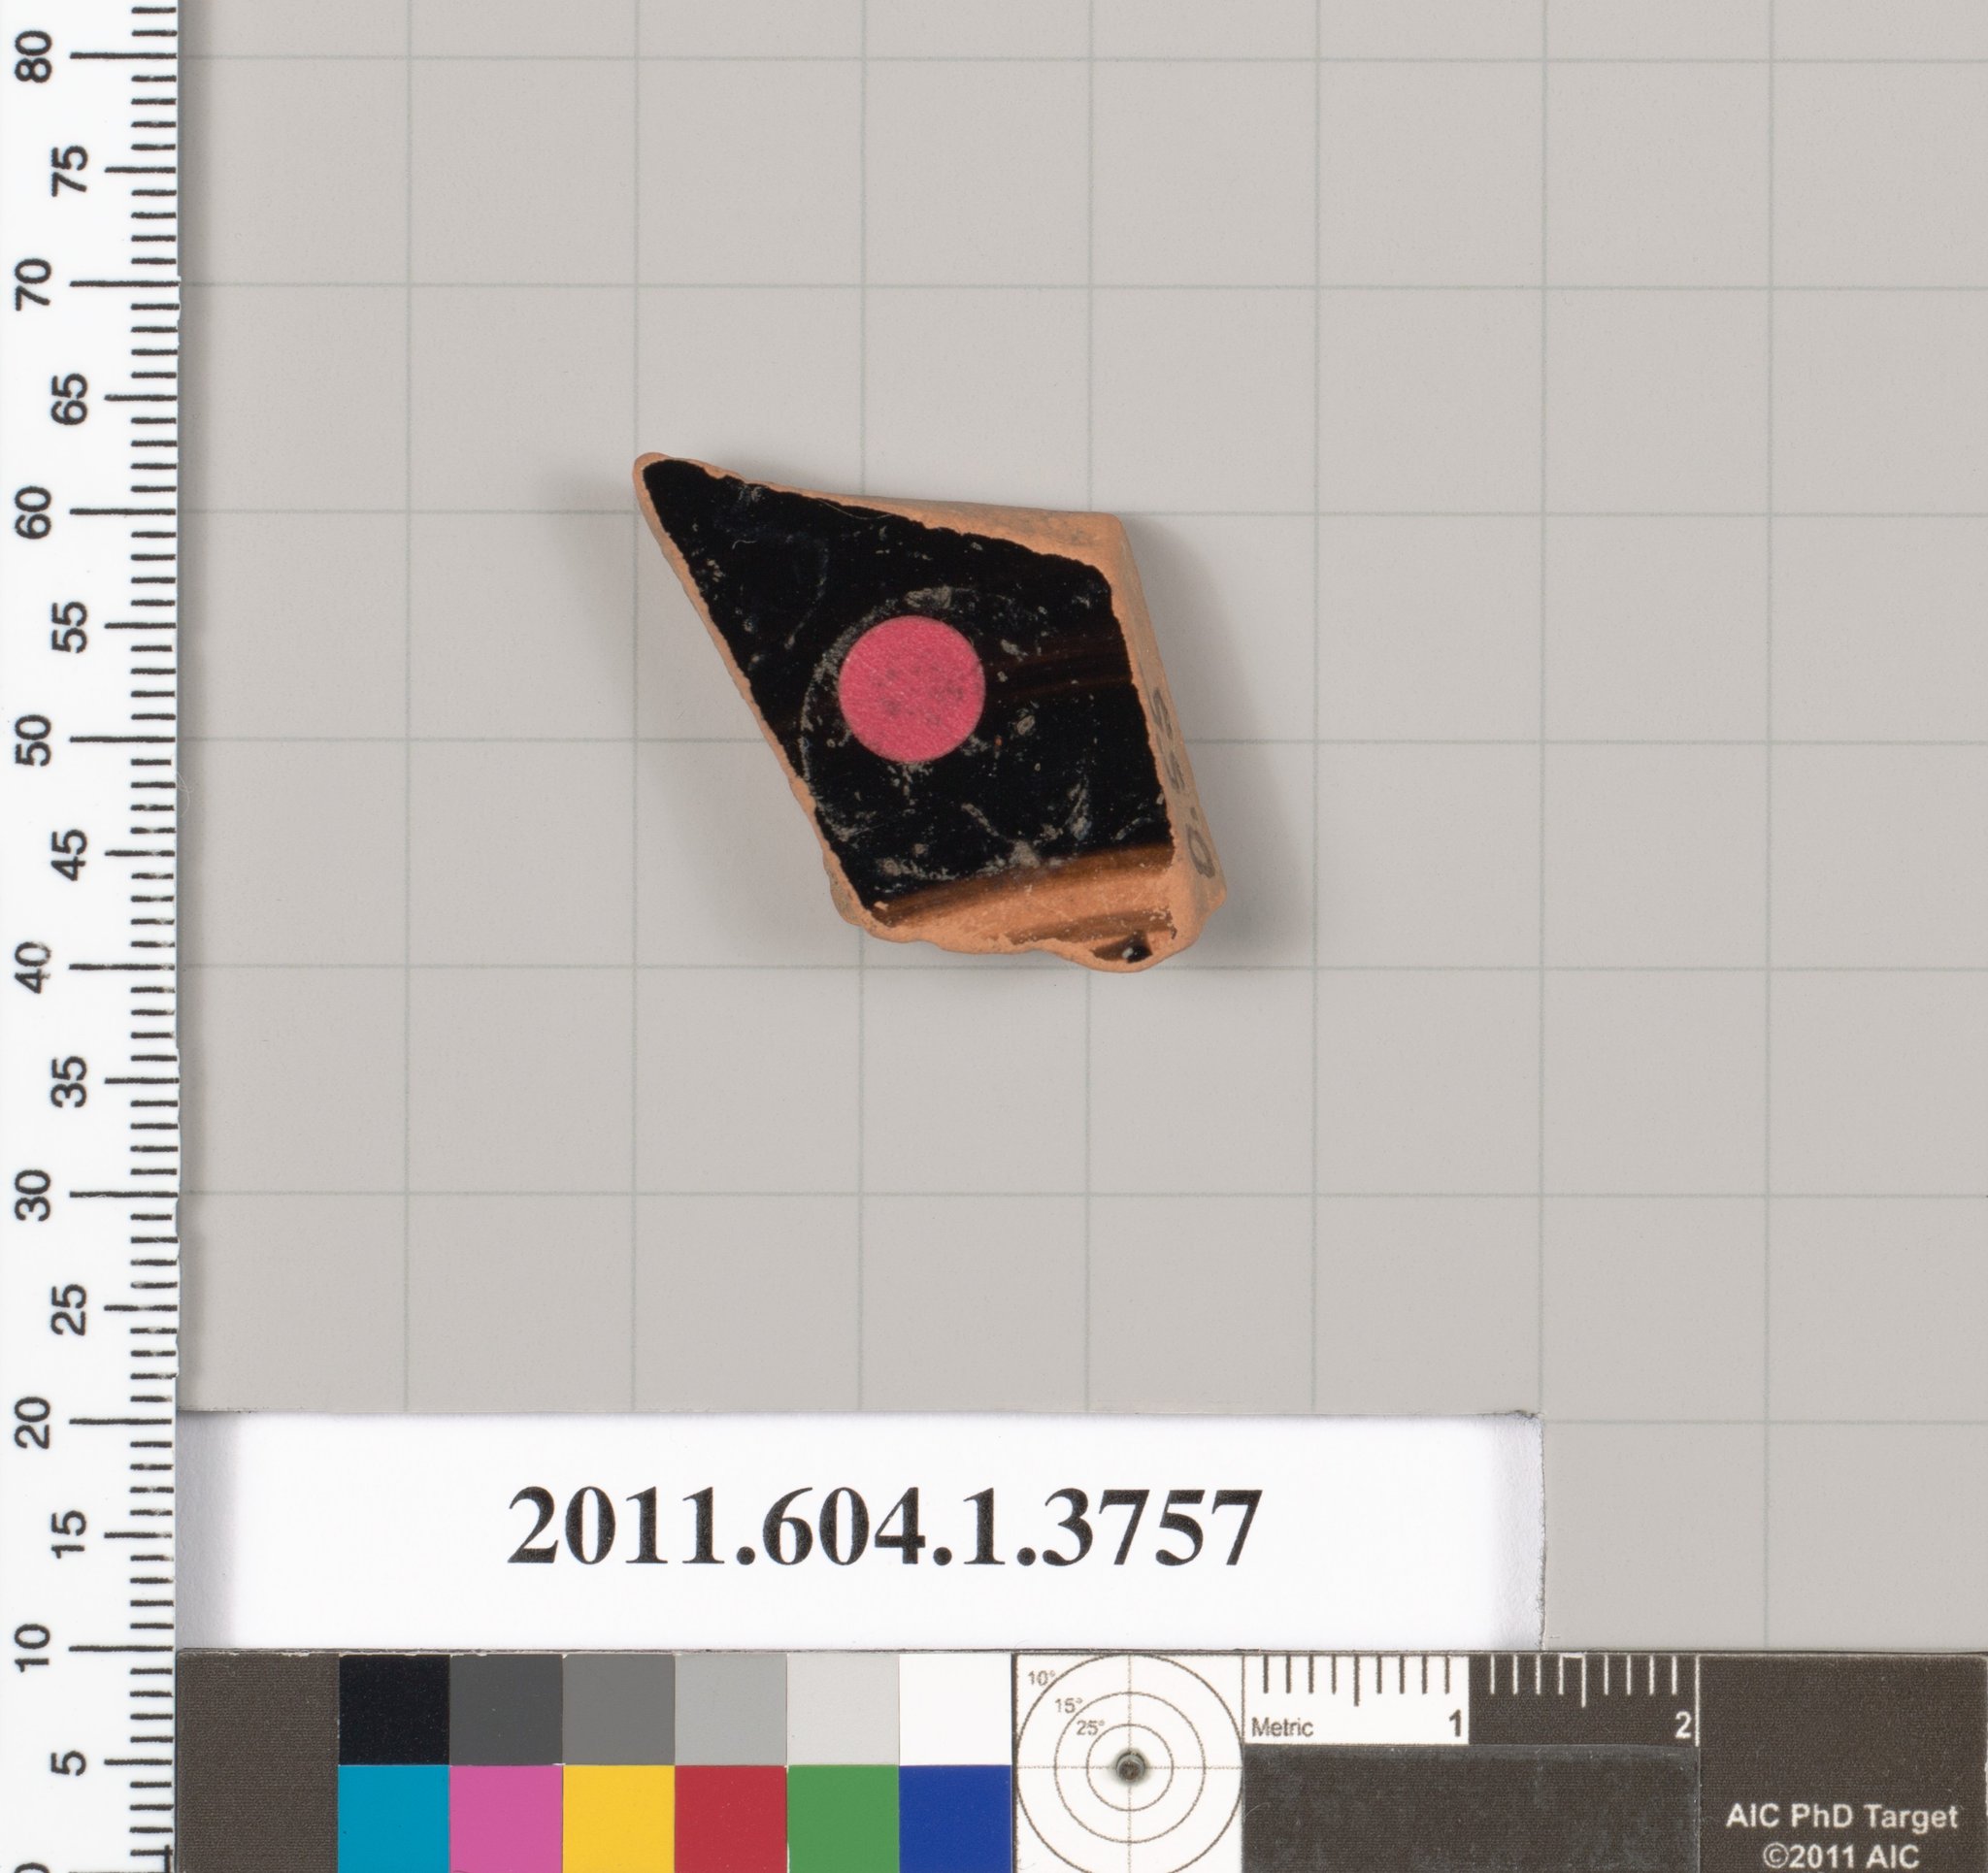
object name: kylix fragment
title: Terracotta fragment of a kylix (drinking cup)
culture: greek, attic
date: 475-451 BCE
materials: terracotta